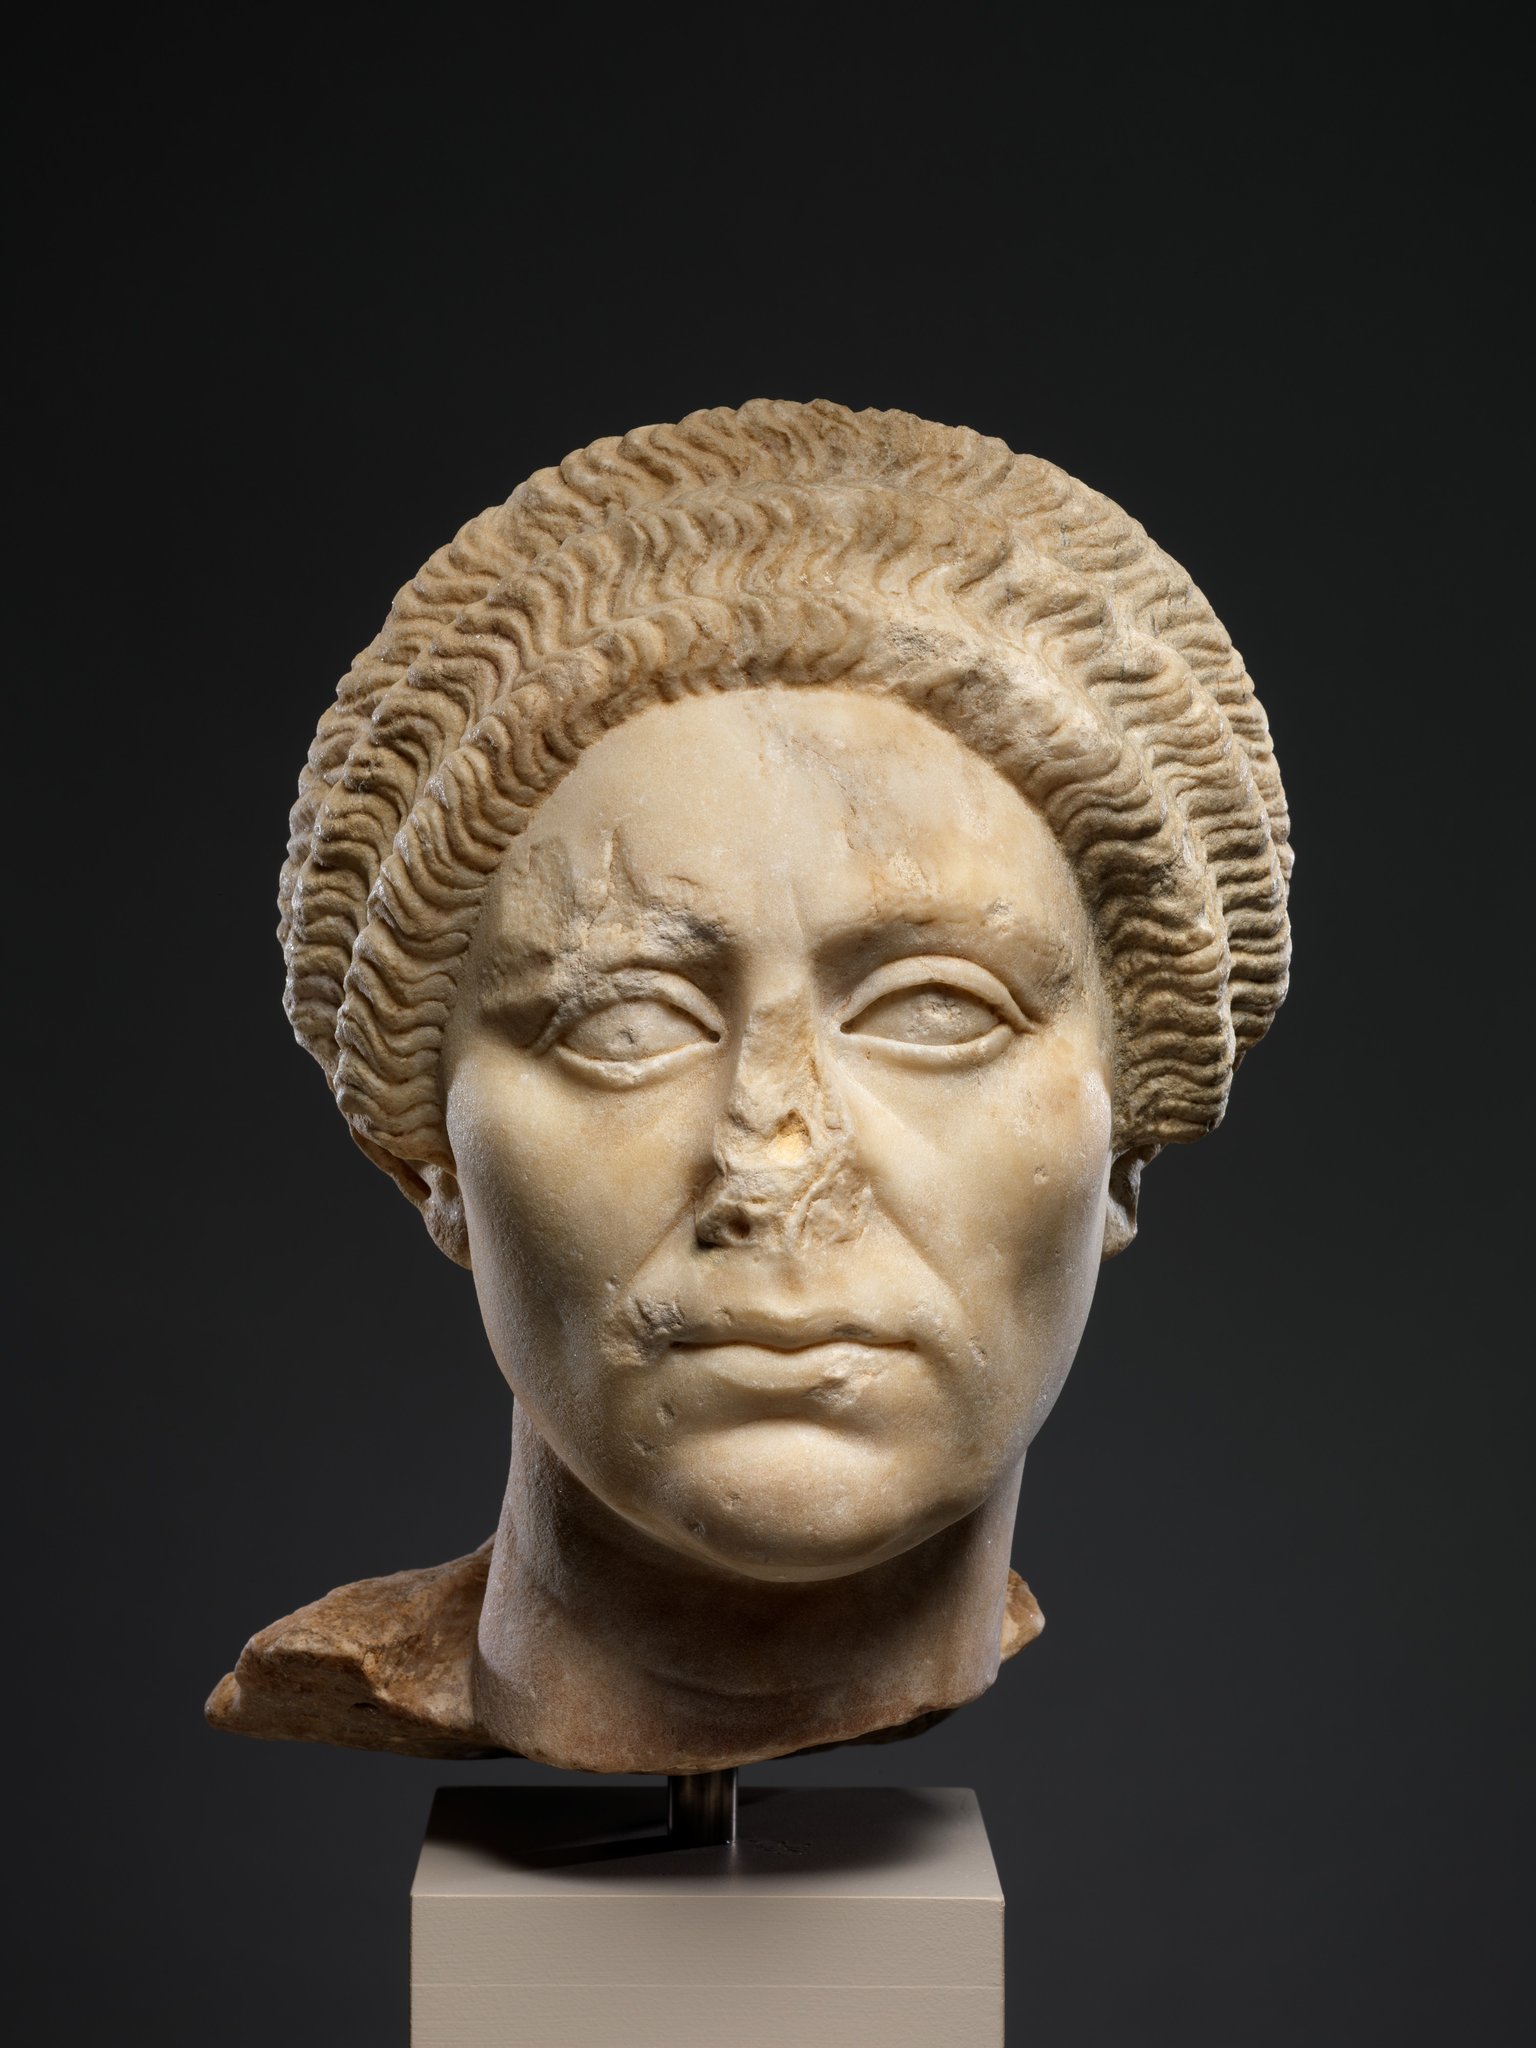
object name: portrait head of a woman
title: Marble head of a woman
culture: roman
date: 110-120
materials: marble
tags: heads,portraits,women